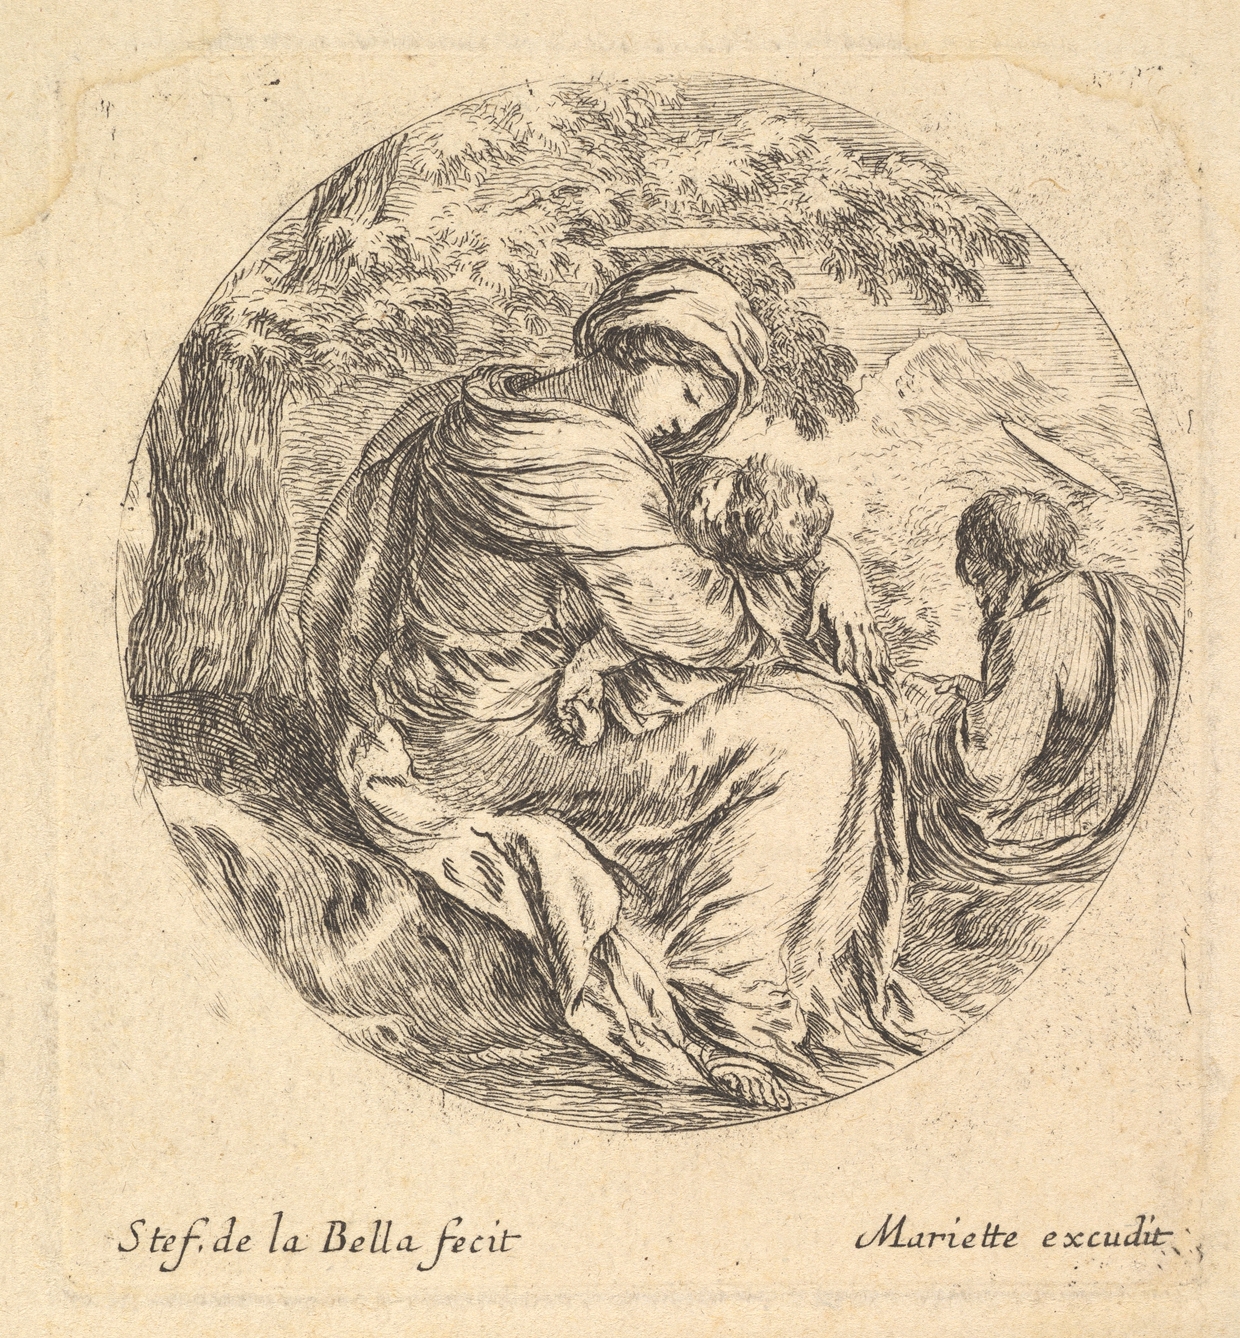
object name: print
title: Rest on the Flight into Egypt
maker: stefano della bella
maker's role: artist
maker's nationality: italian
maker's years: 1610-1664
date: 1641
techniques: etching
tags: christ,holy family,saint joseph,virgin mary